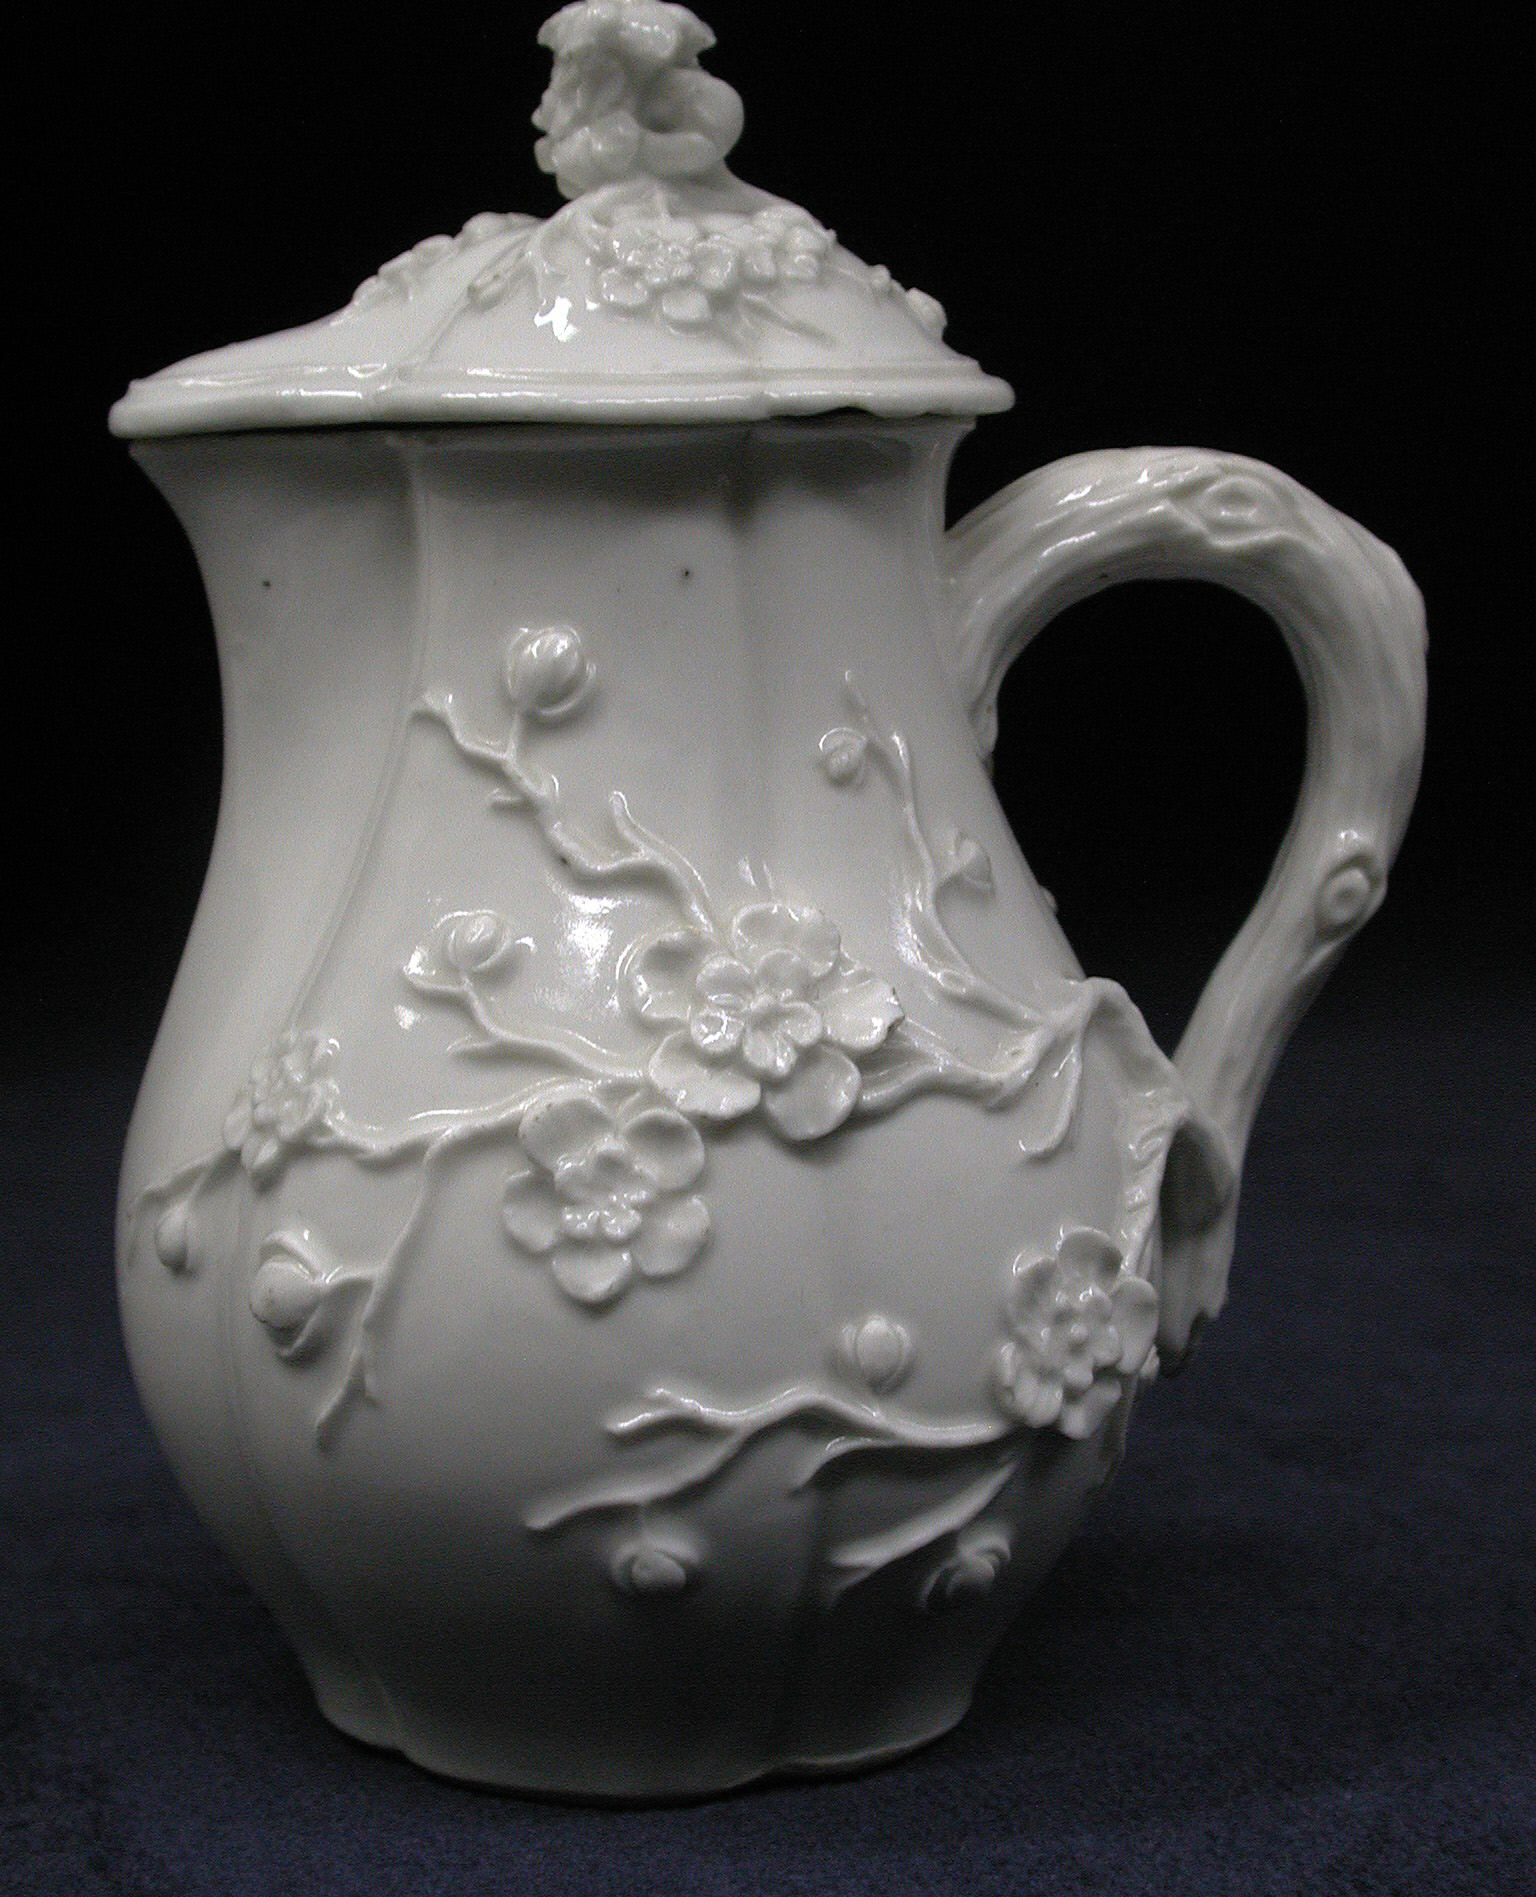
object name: milk jug with cover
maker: sèvres manufactory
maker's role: manufactory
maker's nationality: french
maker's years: 1740-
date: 1780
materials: hard paste porcelain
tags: flowers